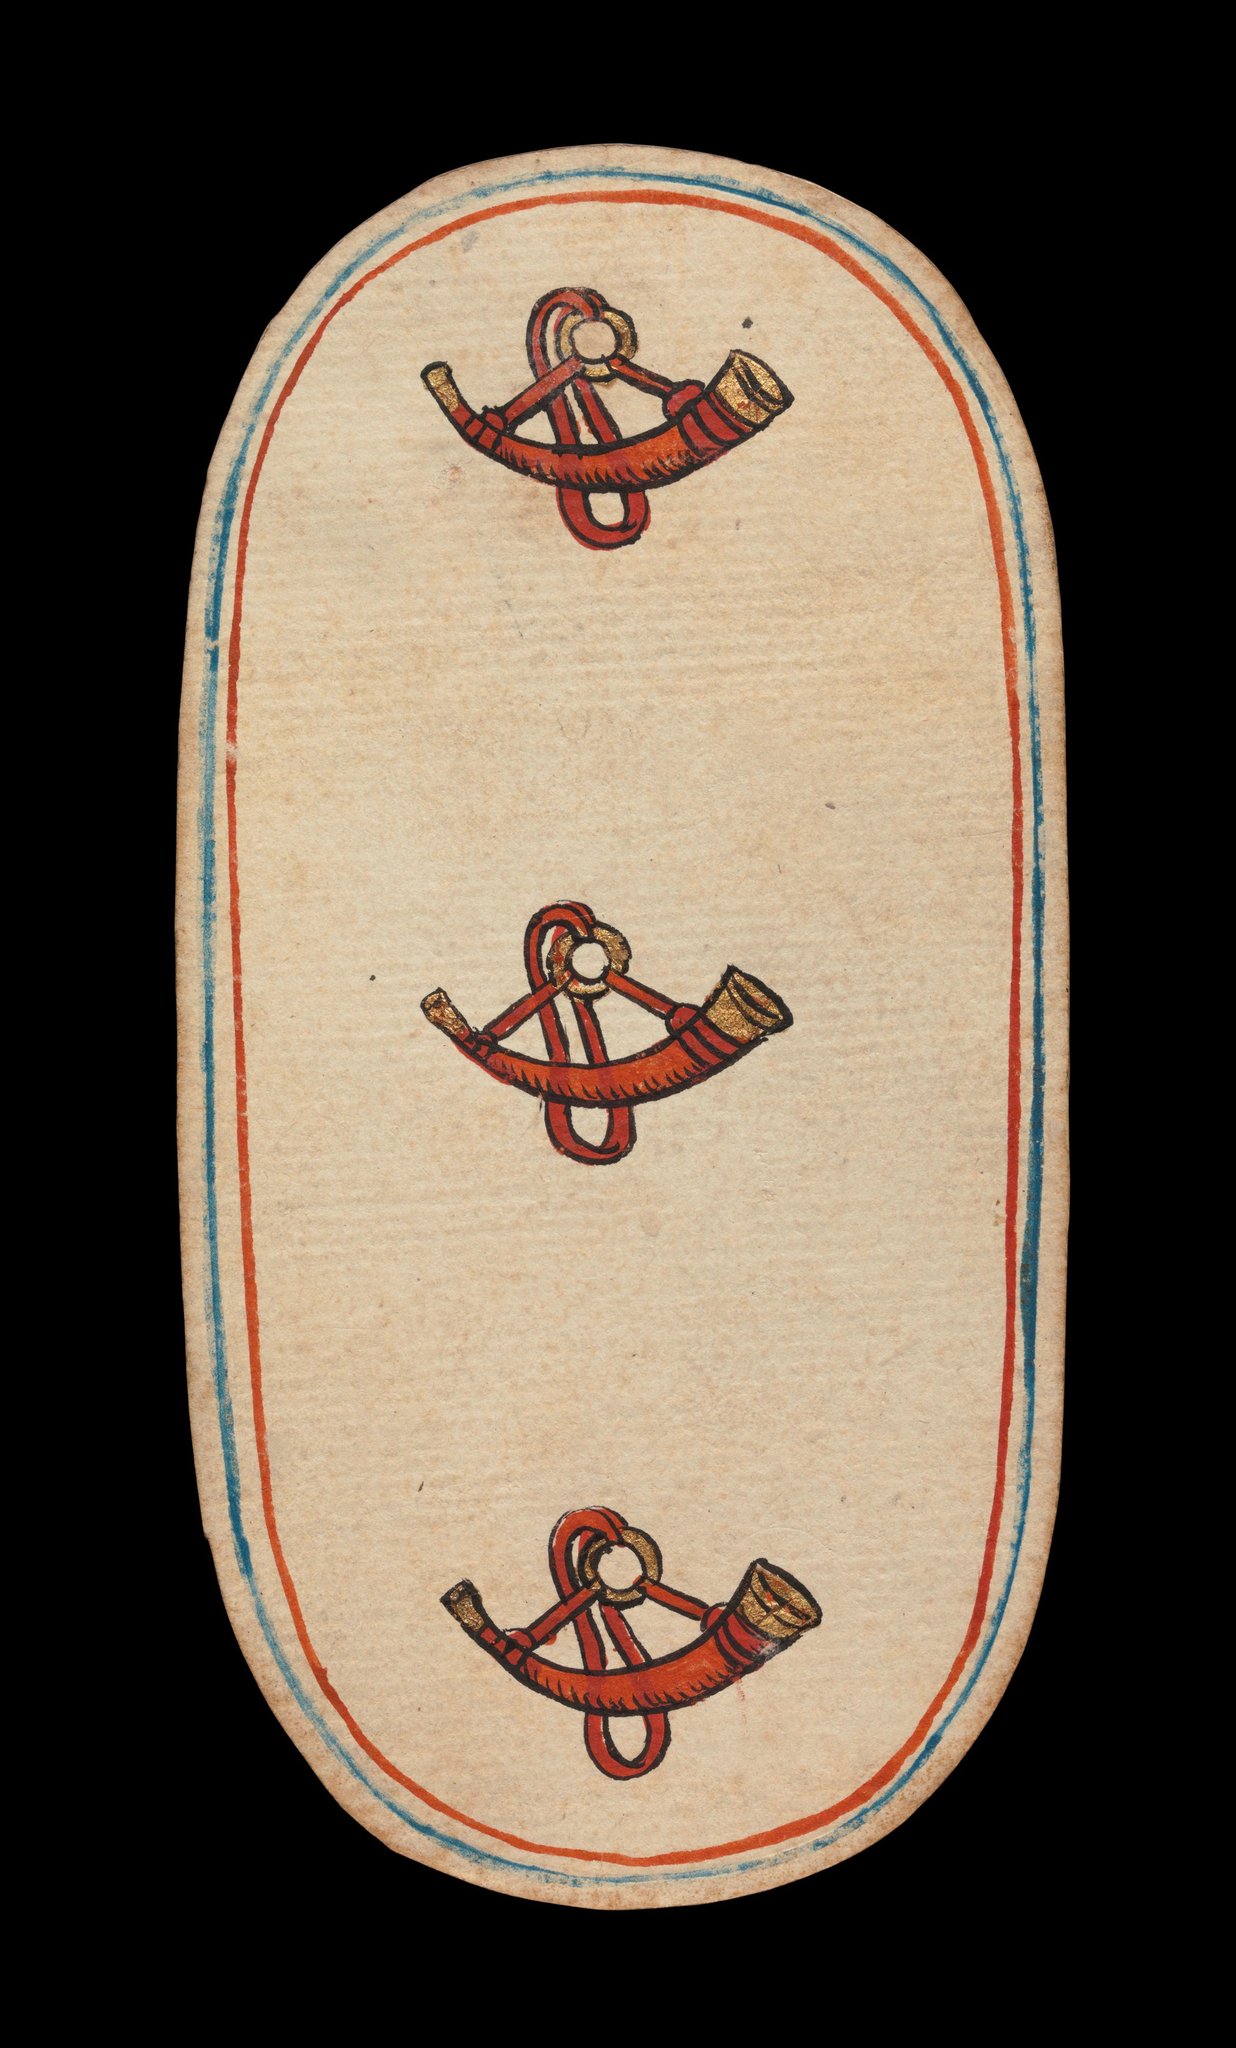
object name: playing card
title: 3 of Horns, from The Cloisters Playing Cards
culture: south netherlandish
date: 1475-1480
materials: glaze, gold, ink, paint, paper, silver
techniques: pen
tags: playing cards,horns,games